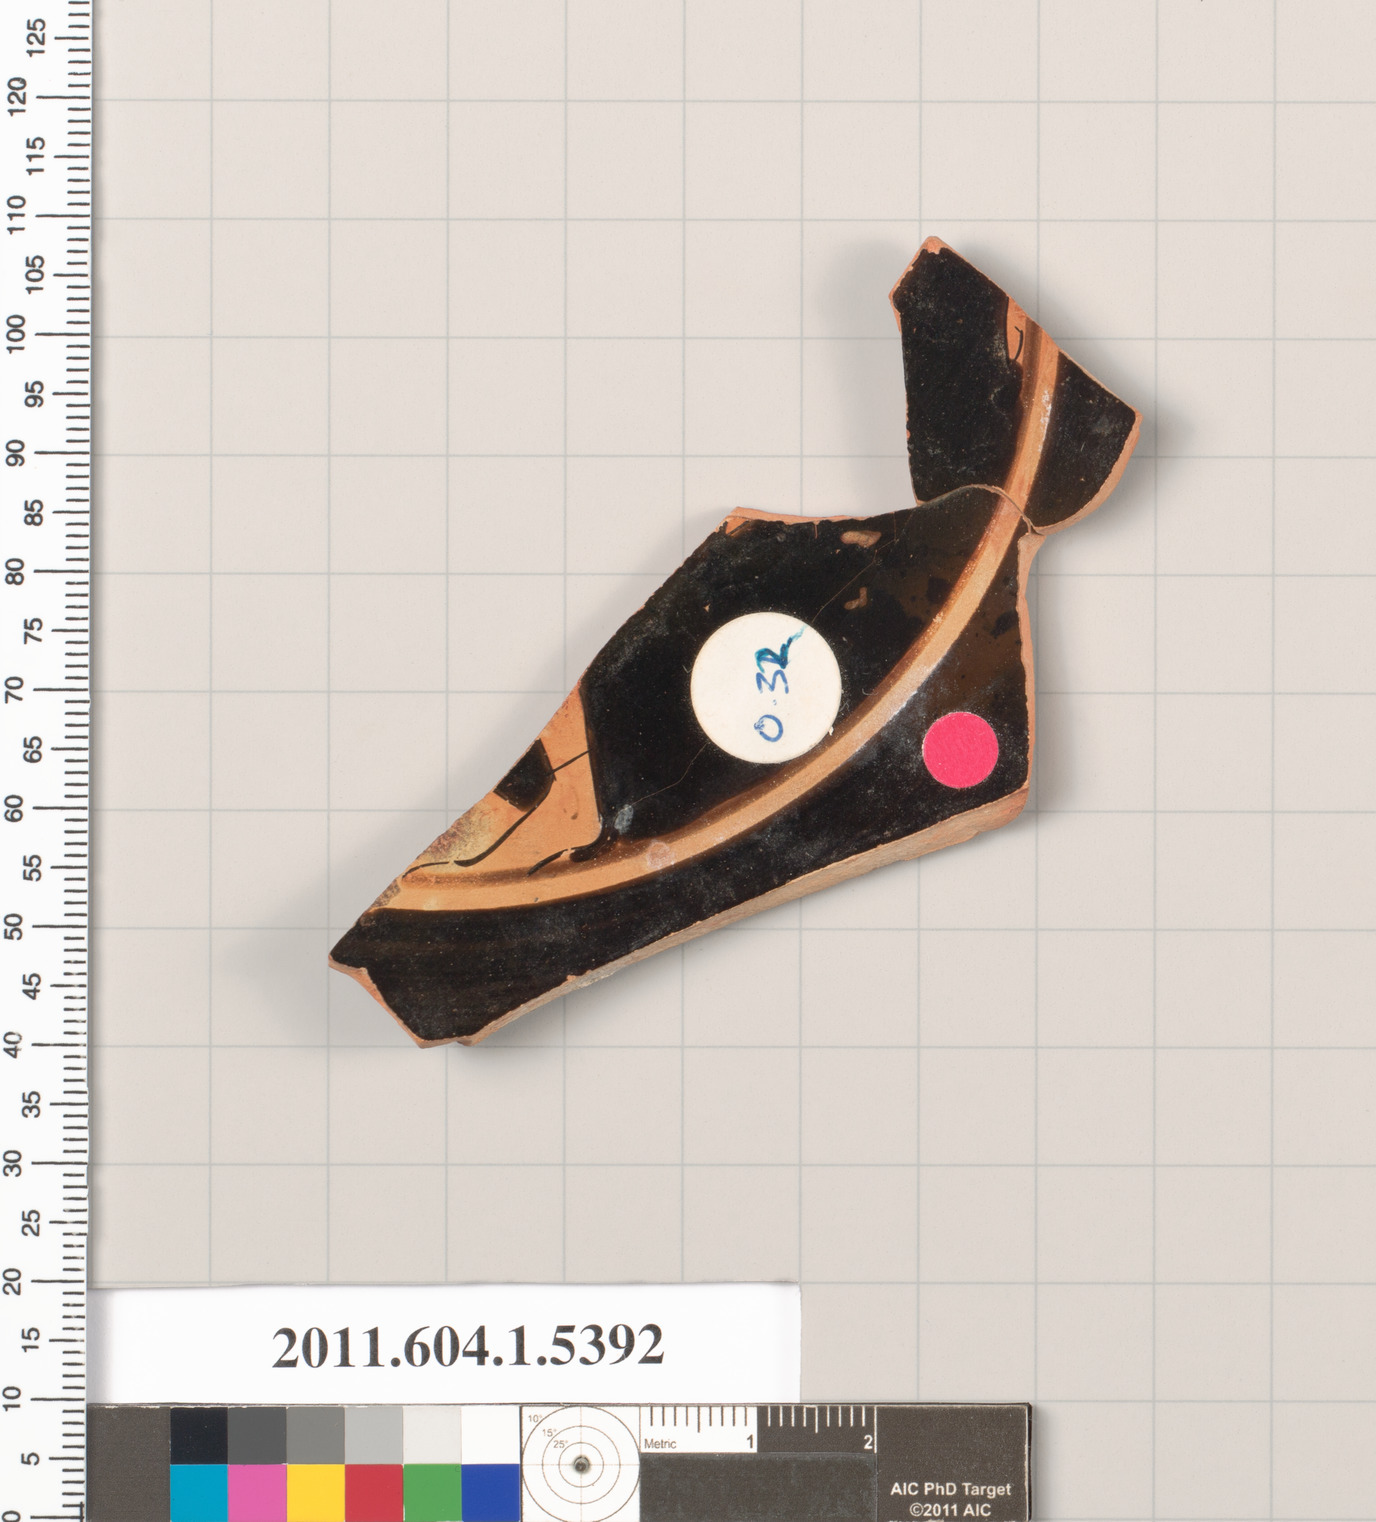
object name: kylix fragment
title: Terracotta fragment of a kylix (drinking cup)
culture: greek, attic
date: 510-490 BCE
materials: terracotta